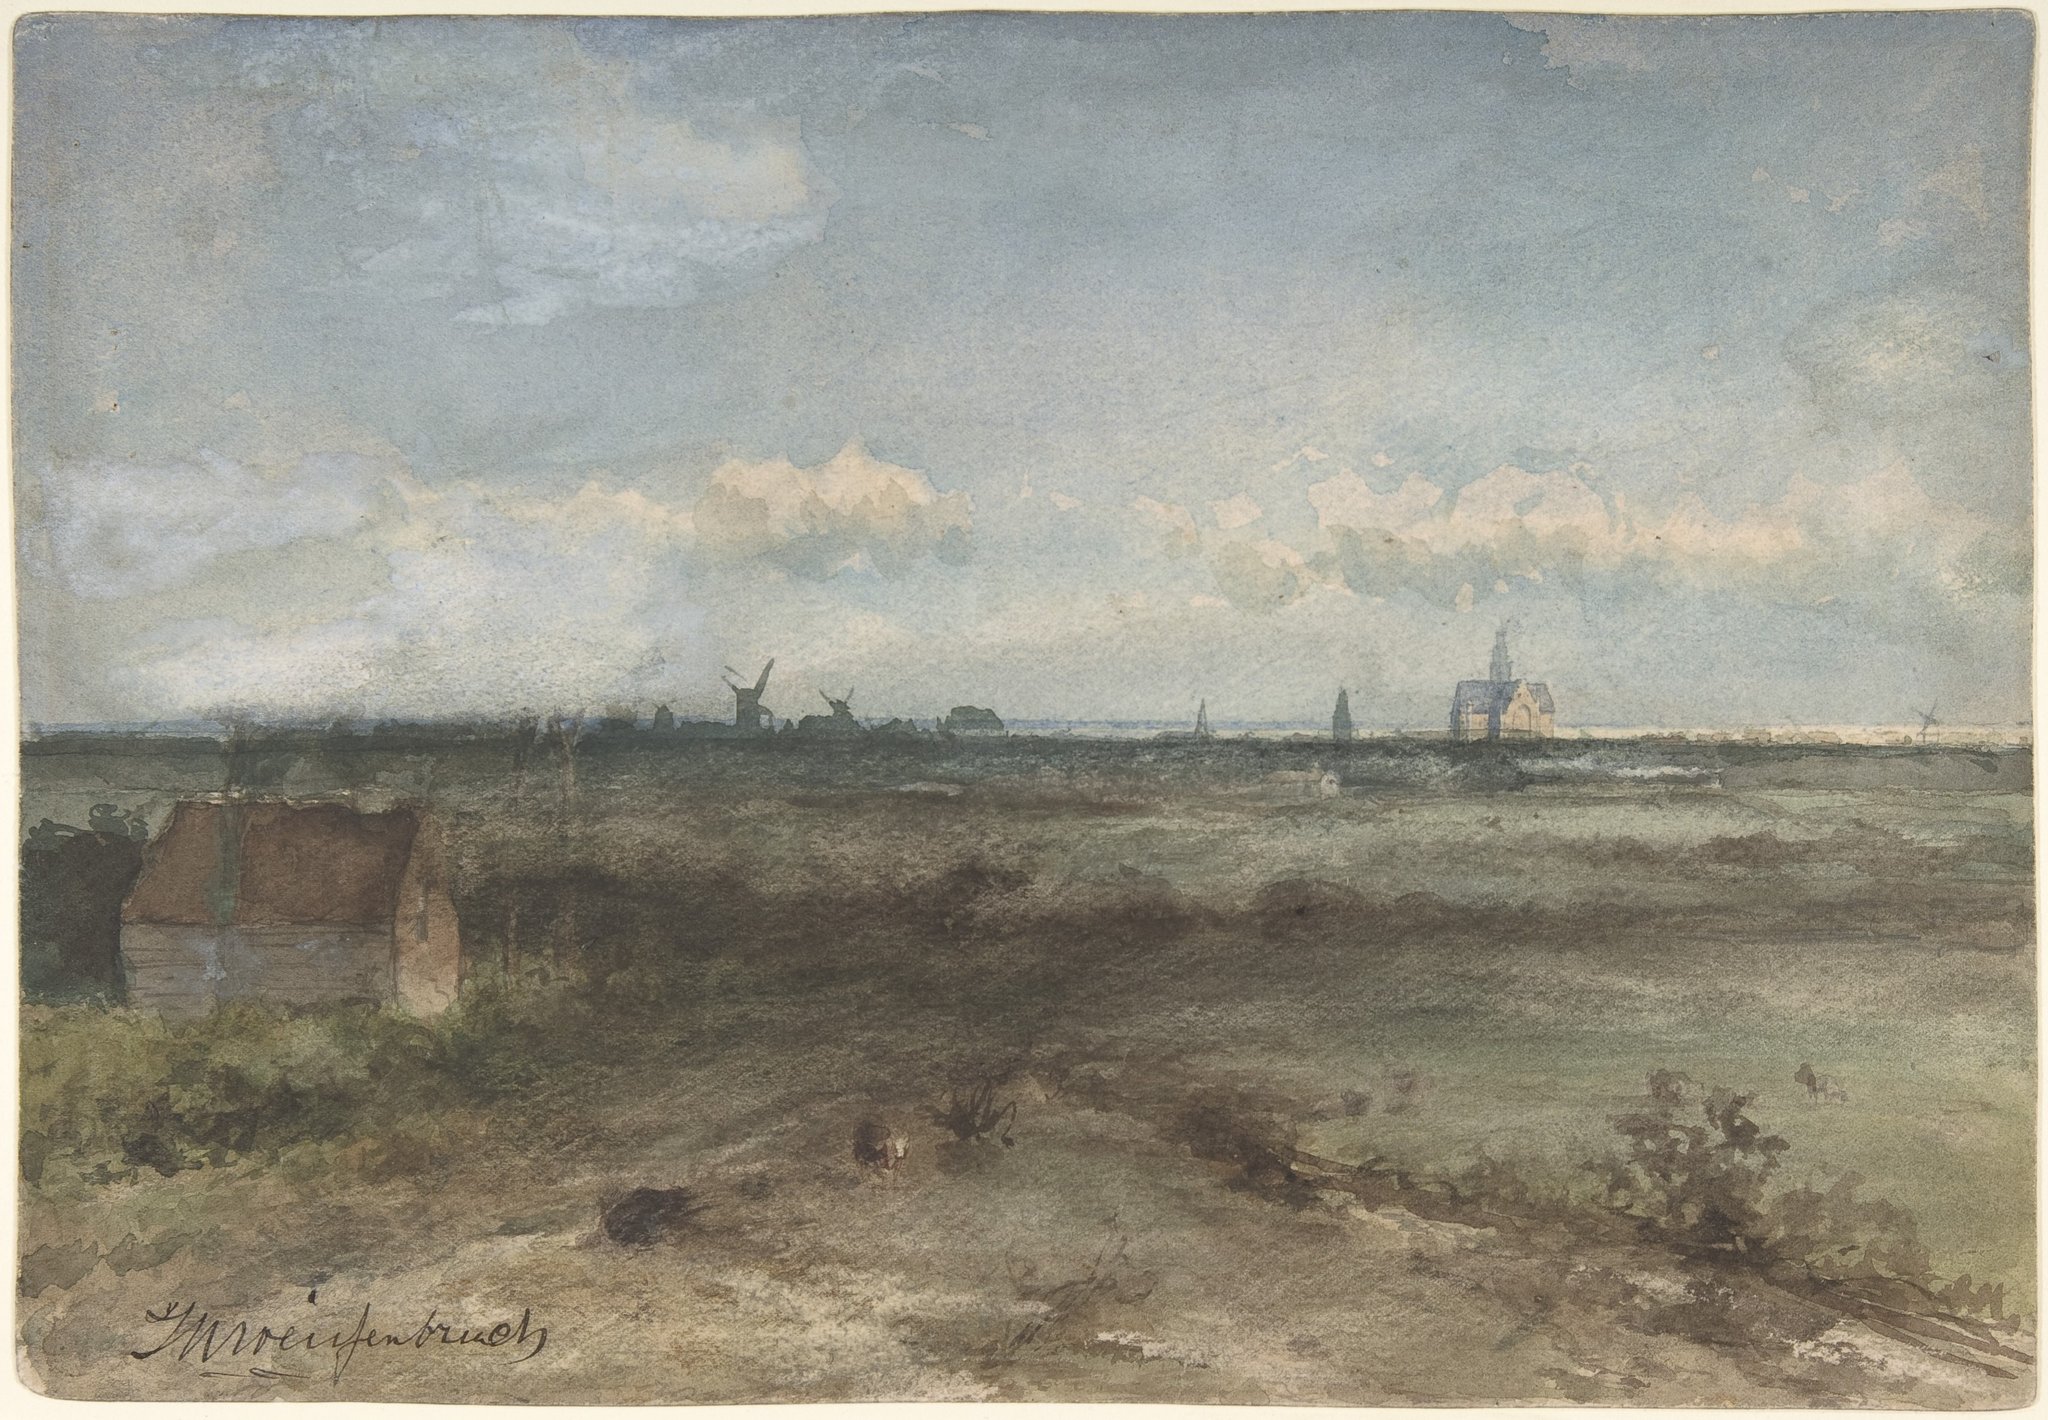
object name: drawing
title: View of Haarlem from the Dunes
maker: jan hendrik weissenbruch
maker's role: artist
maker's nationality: dutch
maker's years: 1824-1903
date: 1834-1933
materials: watercolor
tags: houses,landscapes